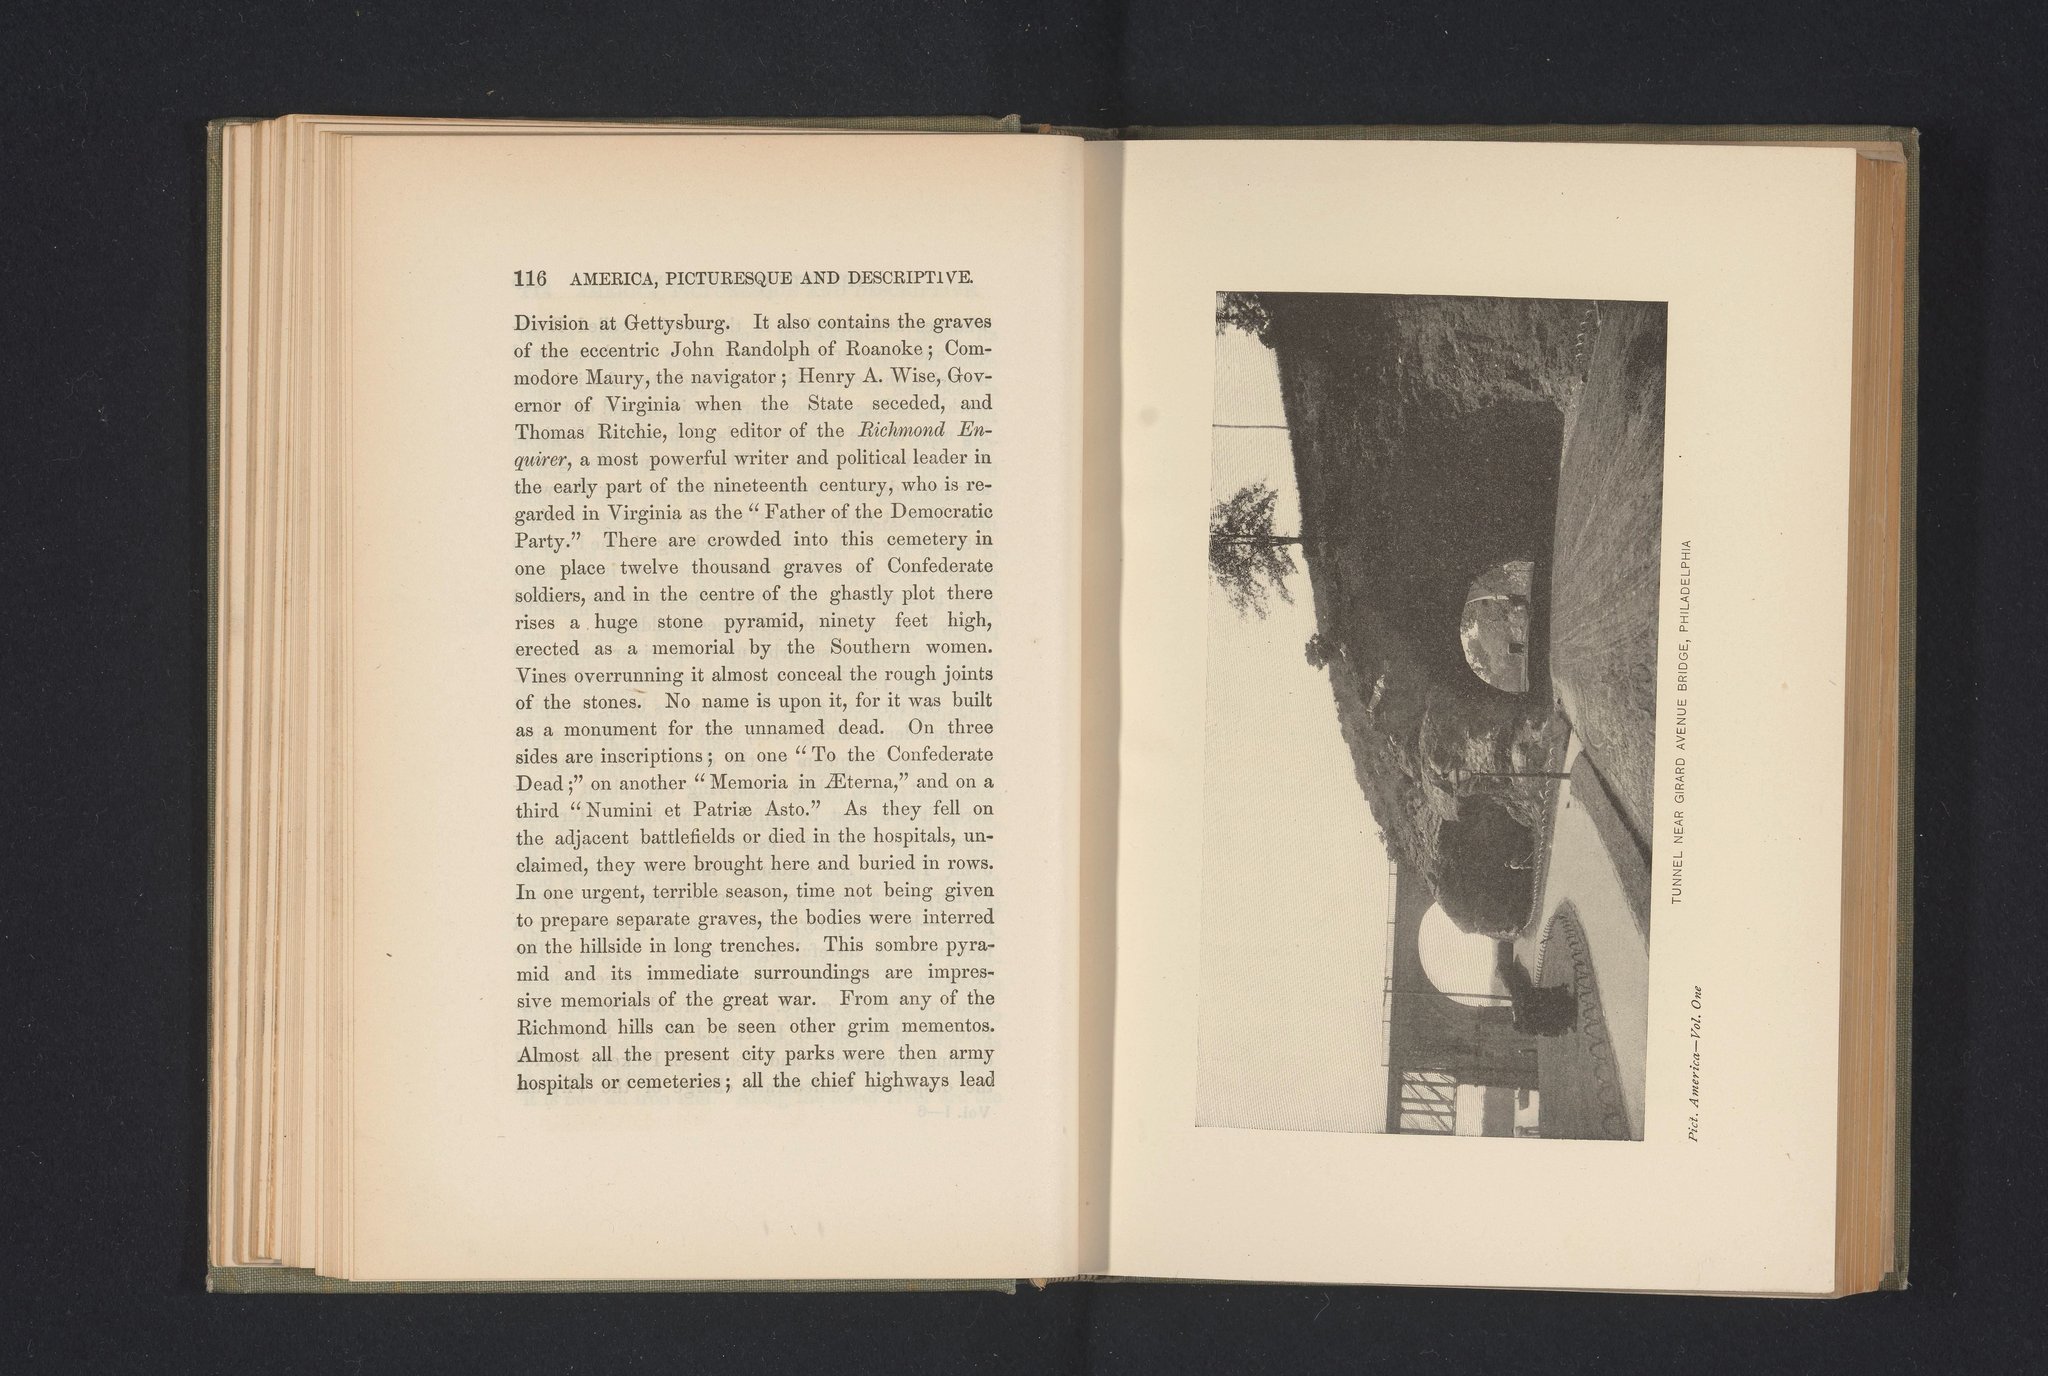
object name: page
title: Tunnel near Grand Avenue Bridge, Philadelphia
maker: Anonymous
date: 1890-1900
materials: paper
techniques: autotype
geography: philadelphia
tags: underground road, tunnel, bridge